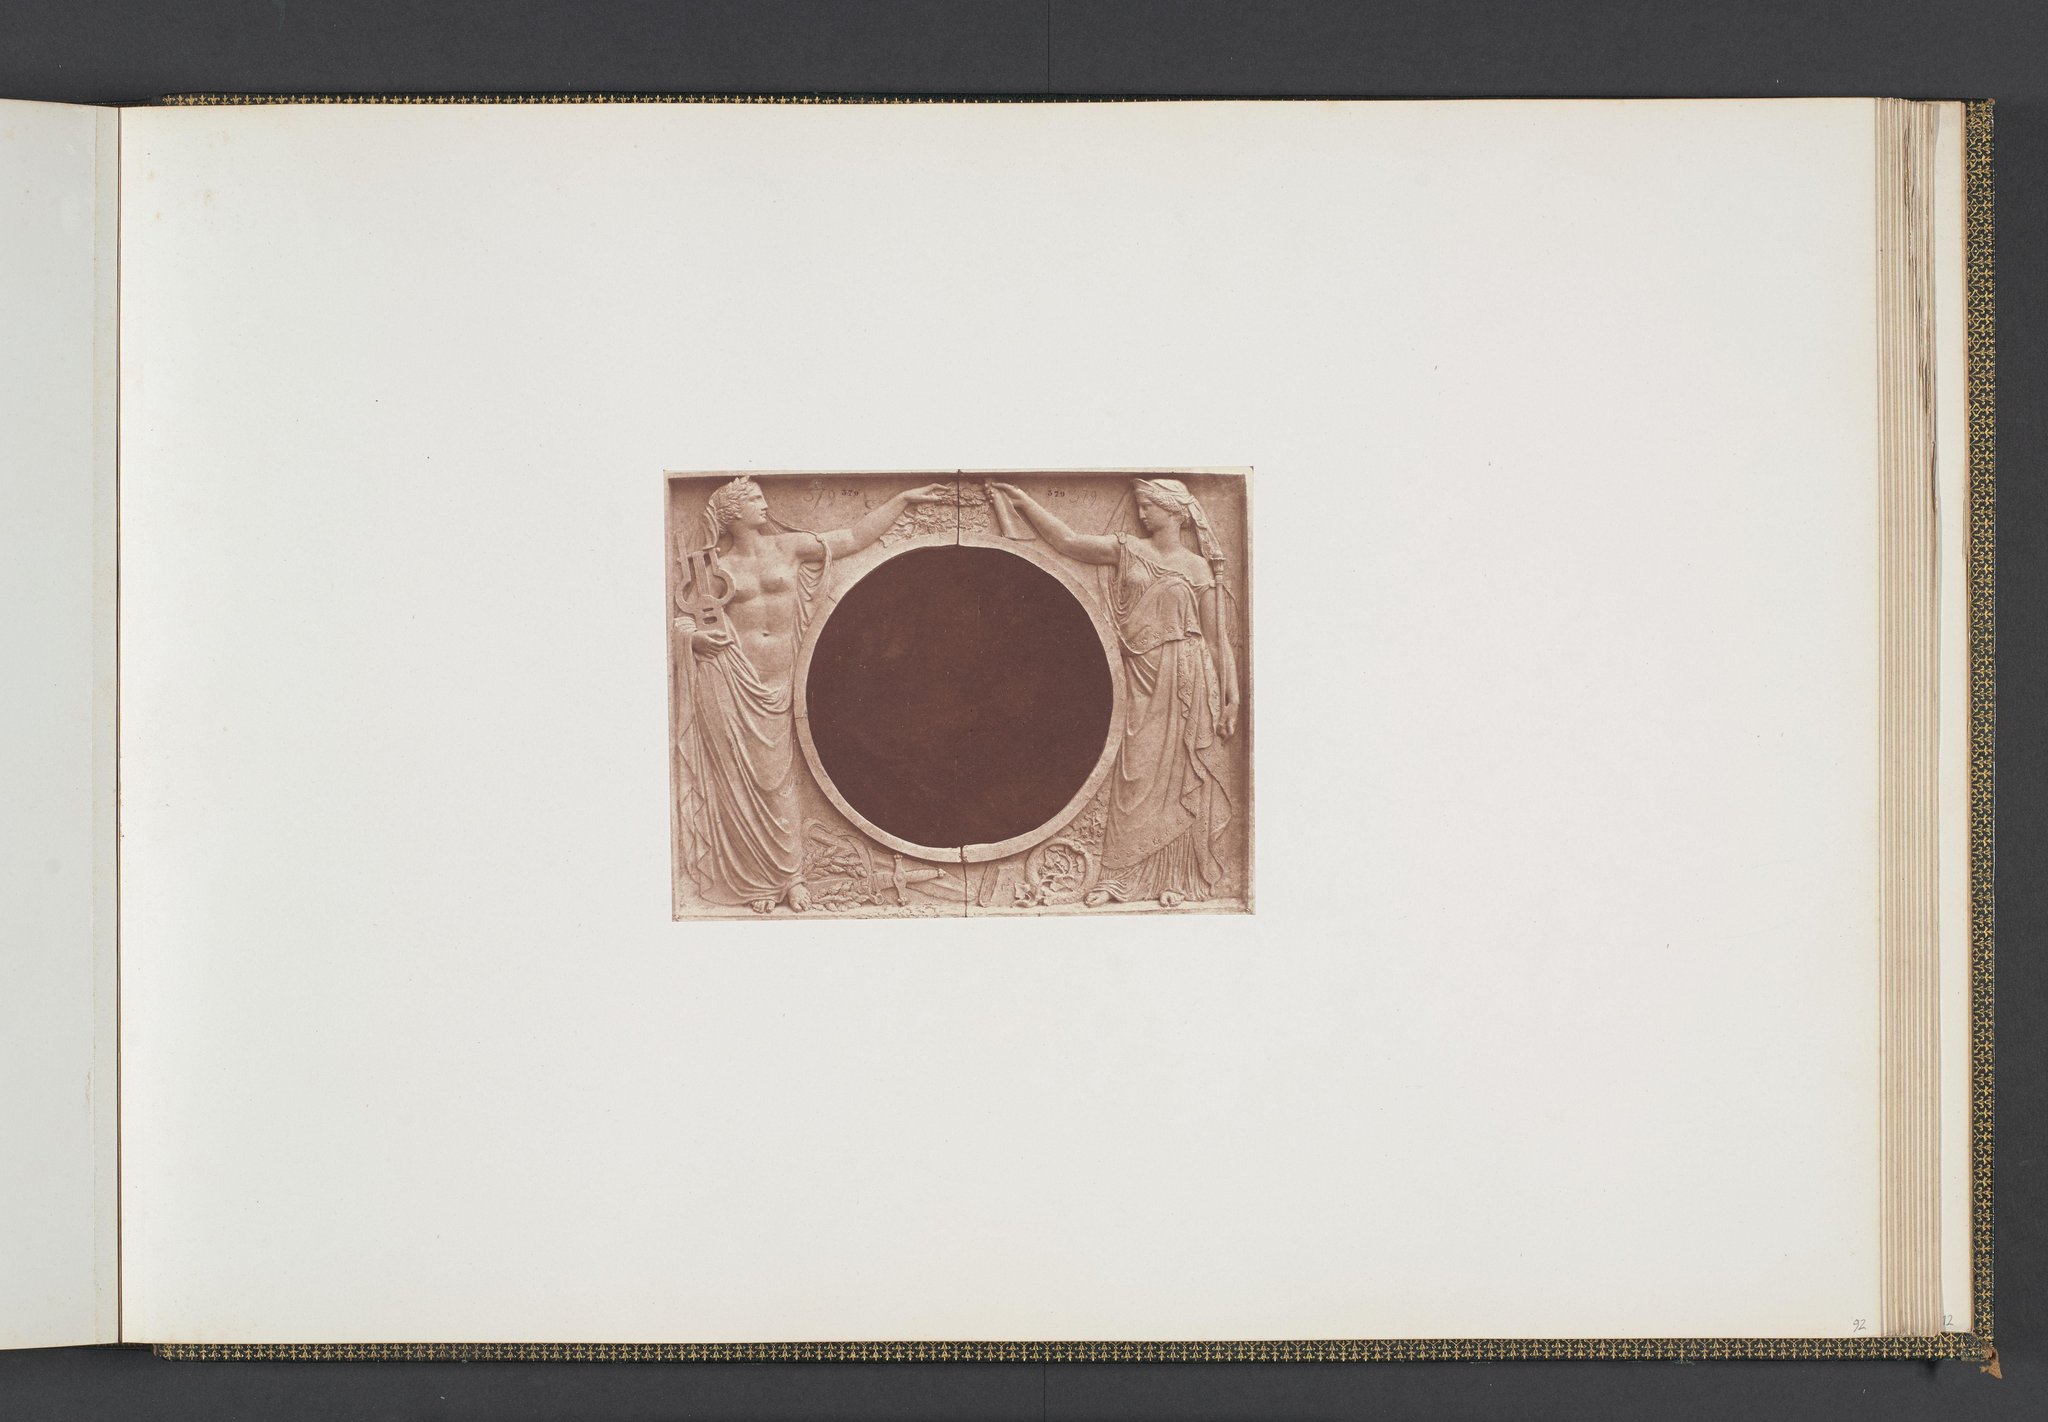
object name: photograph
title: Gipsmodellen voor beeldhouwwerken op het Palais du Louvre: "La Poésie et la Philosophie" door Pierre Loison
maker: édouard denis baldus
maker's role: fotograaf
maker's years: 1813-1889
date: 1855-1857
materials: paper, photographic support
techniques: salted paper print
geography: paris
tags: piece of sculpture, reproduction of a piece of sculpture, permanent exhibition, museum, paris, tuileries palace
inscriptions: number: ‘379’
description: Onderdeel van Réunion des Tuileries au Louvre 1852-1857, album 2.